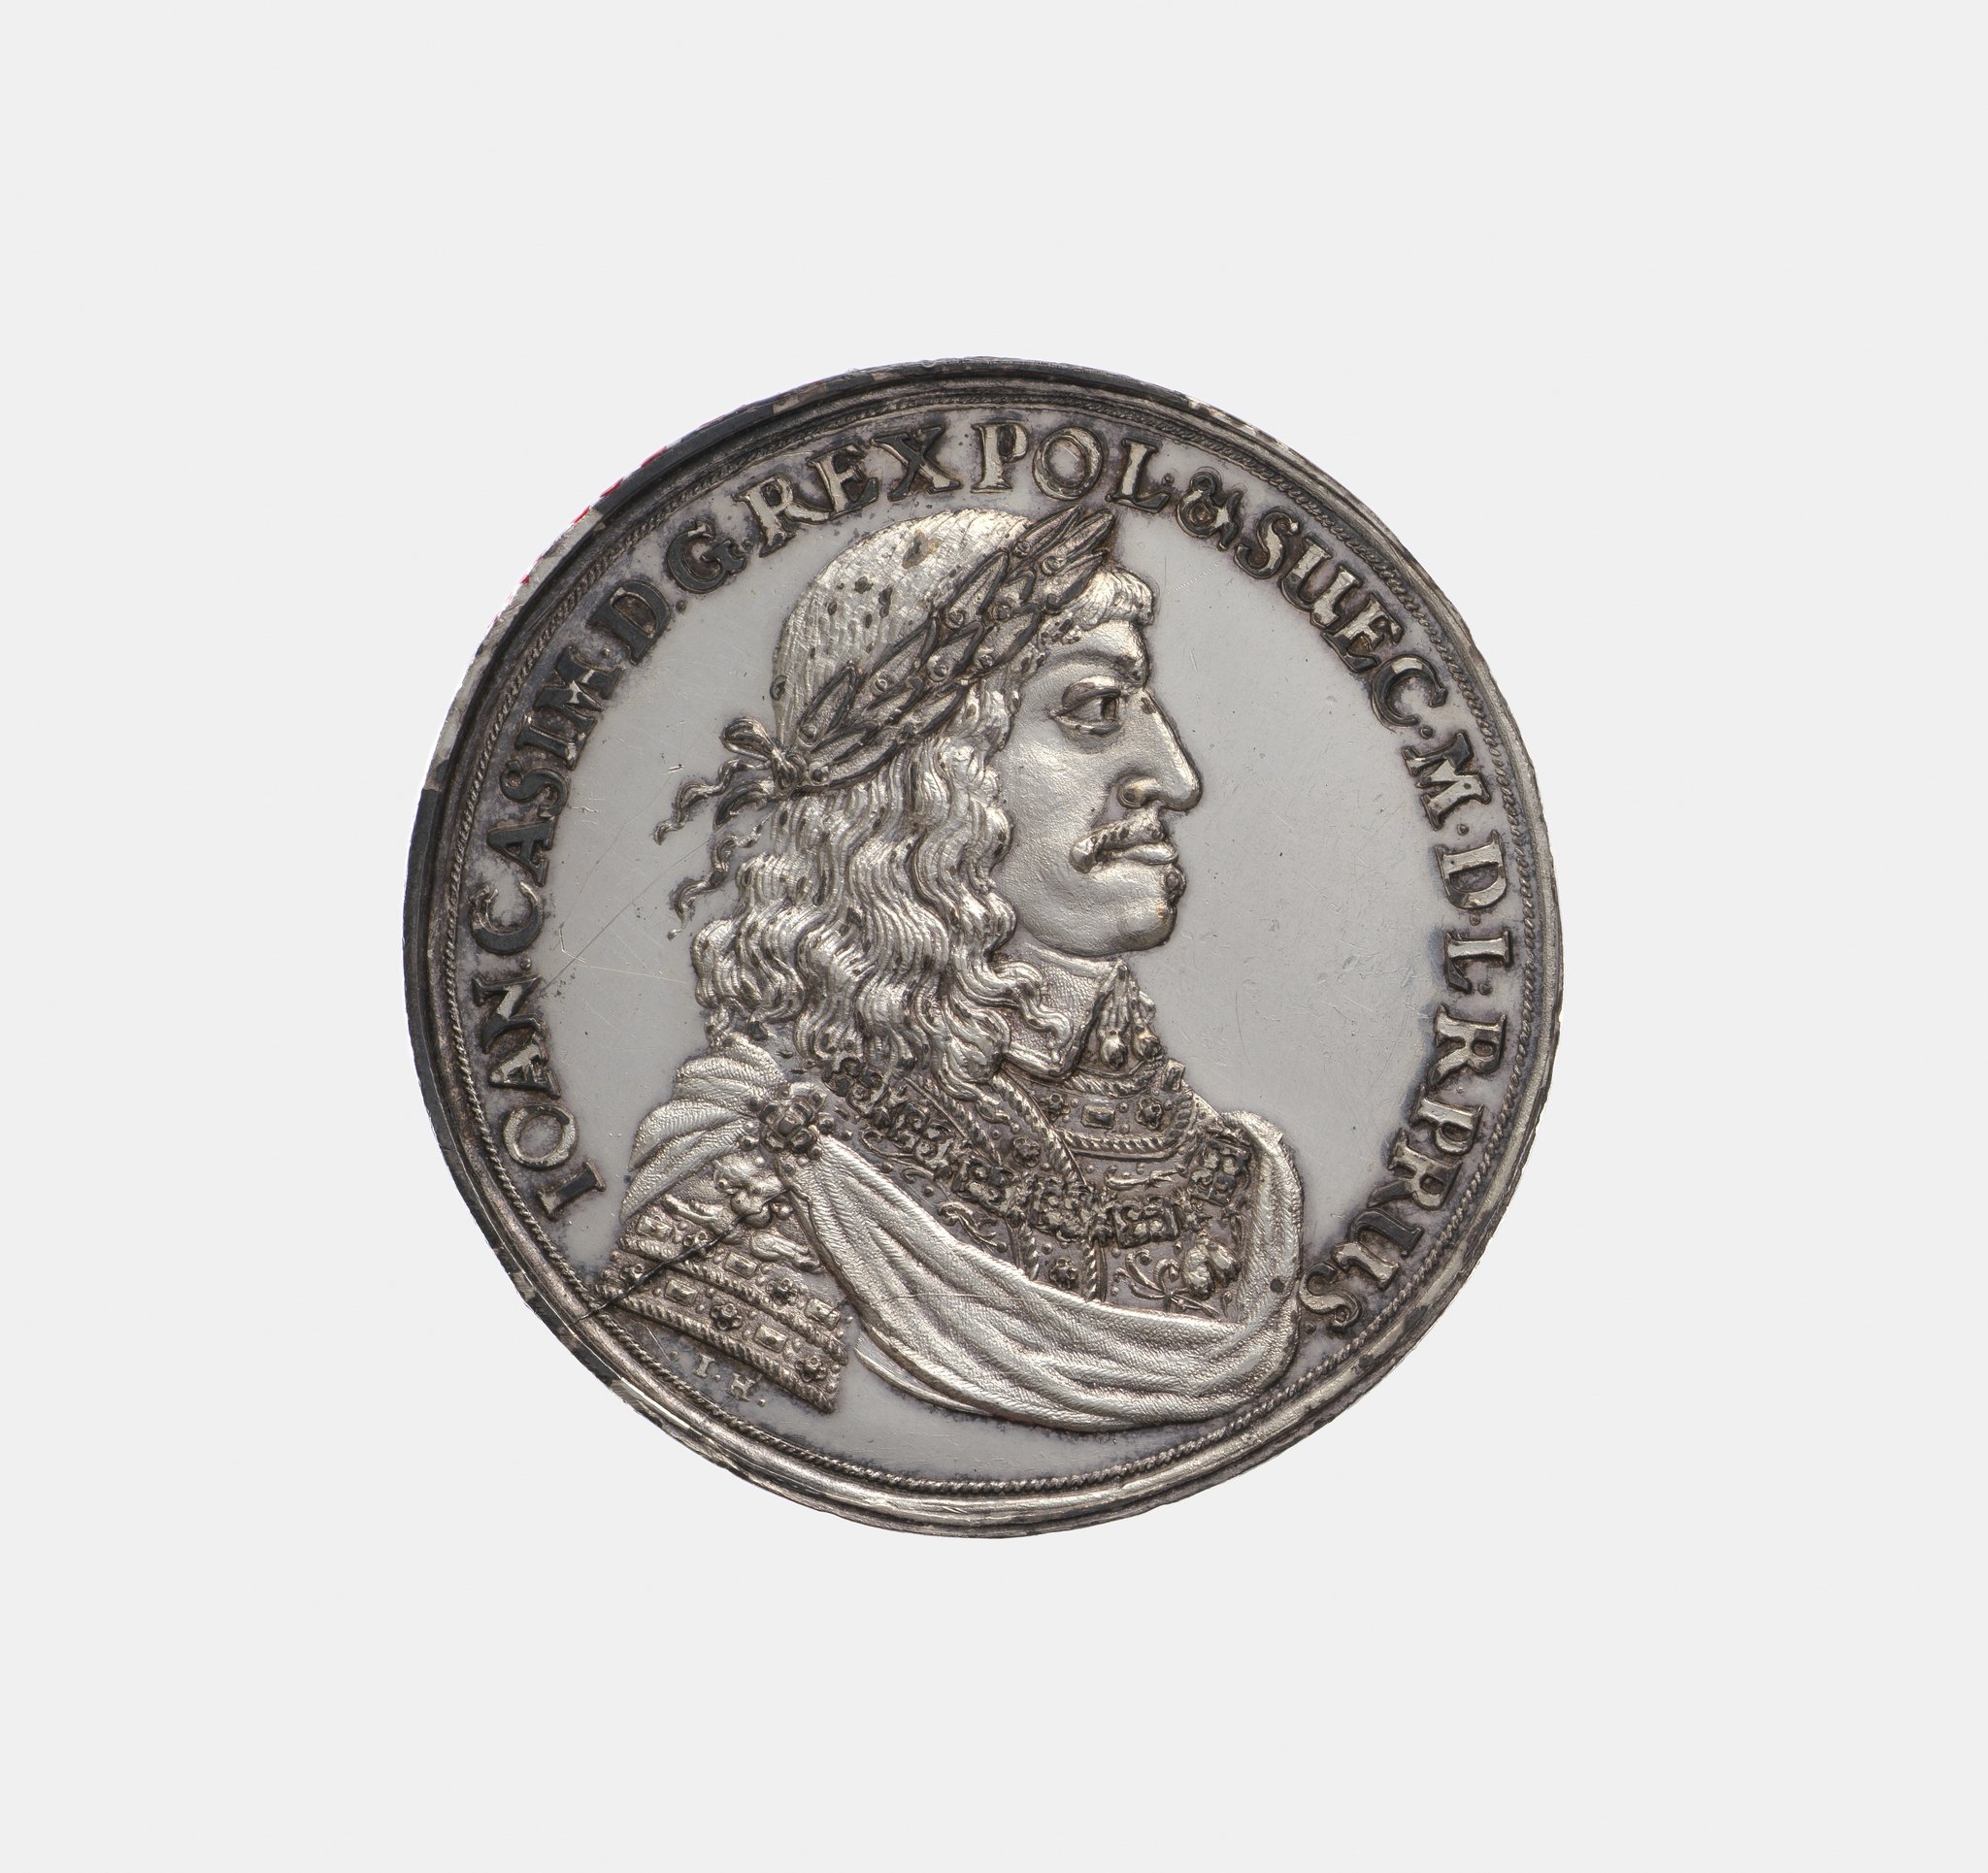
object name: medal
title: John Casimir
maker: johann hoehn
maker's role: artist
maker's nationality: german, danzig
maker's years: 1637-1693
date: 1660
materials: silver